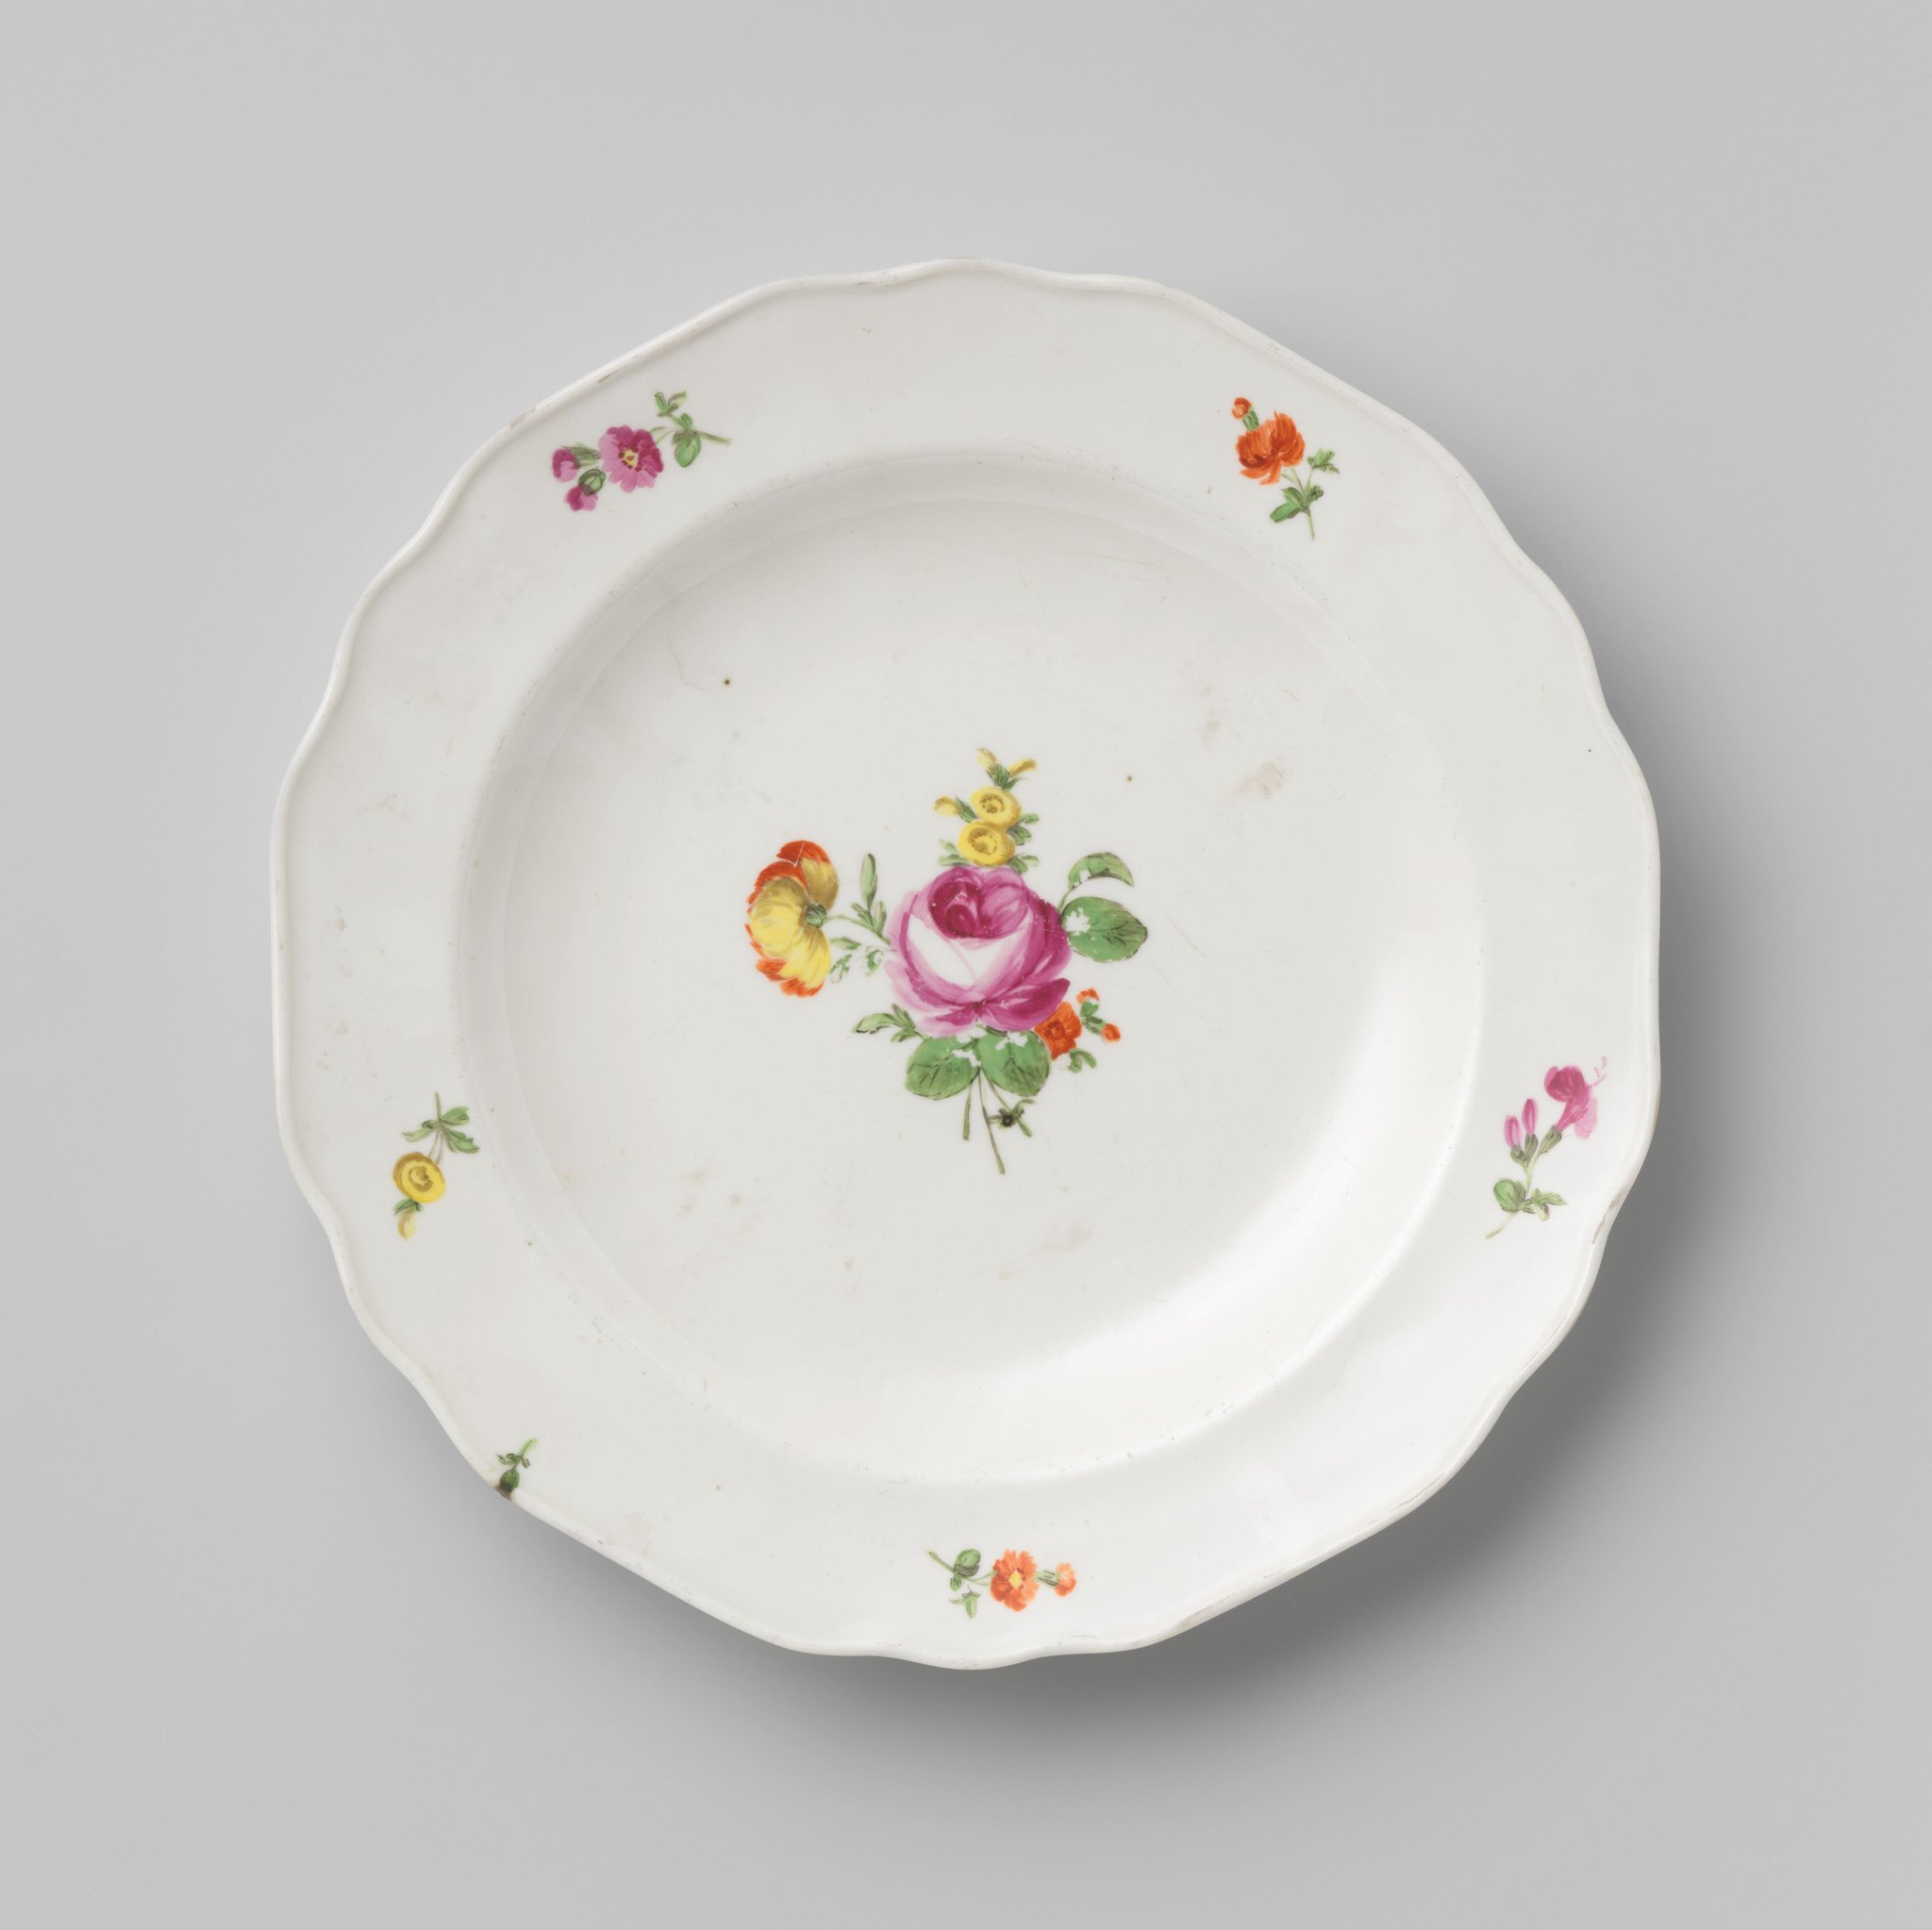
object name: plate dish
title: Plate with a bouquet and flower sprays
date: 1800-1849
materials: glaze, paint, porcelain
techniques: firing, forming, turning, vitrification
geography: vienna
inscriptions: mark: ‘schild/ P/ 32/ 40/ 89’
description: Bord van porselein met een gelobde rand, beschilderd op het glazuur in rood, roze, groen en geel. Op het plat een boeket van verschillende bloemen (o.a. pioenroos) omgeven door losse takjes en op de rand vijf bloemtakken. Gemerkt op de onderzijde met het schild, de letter P en de nummers 32, 40 en 89.